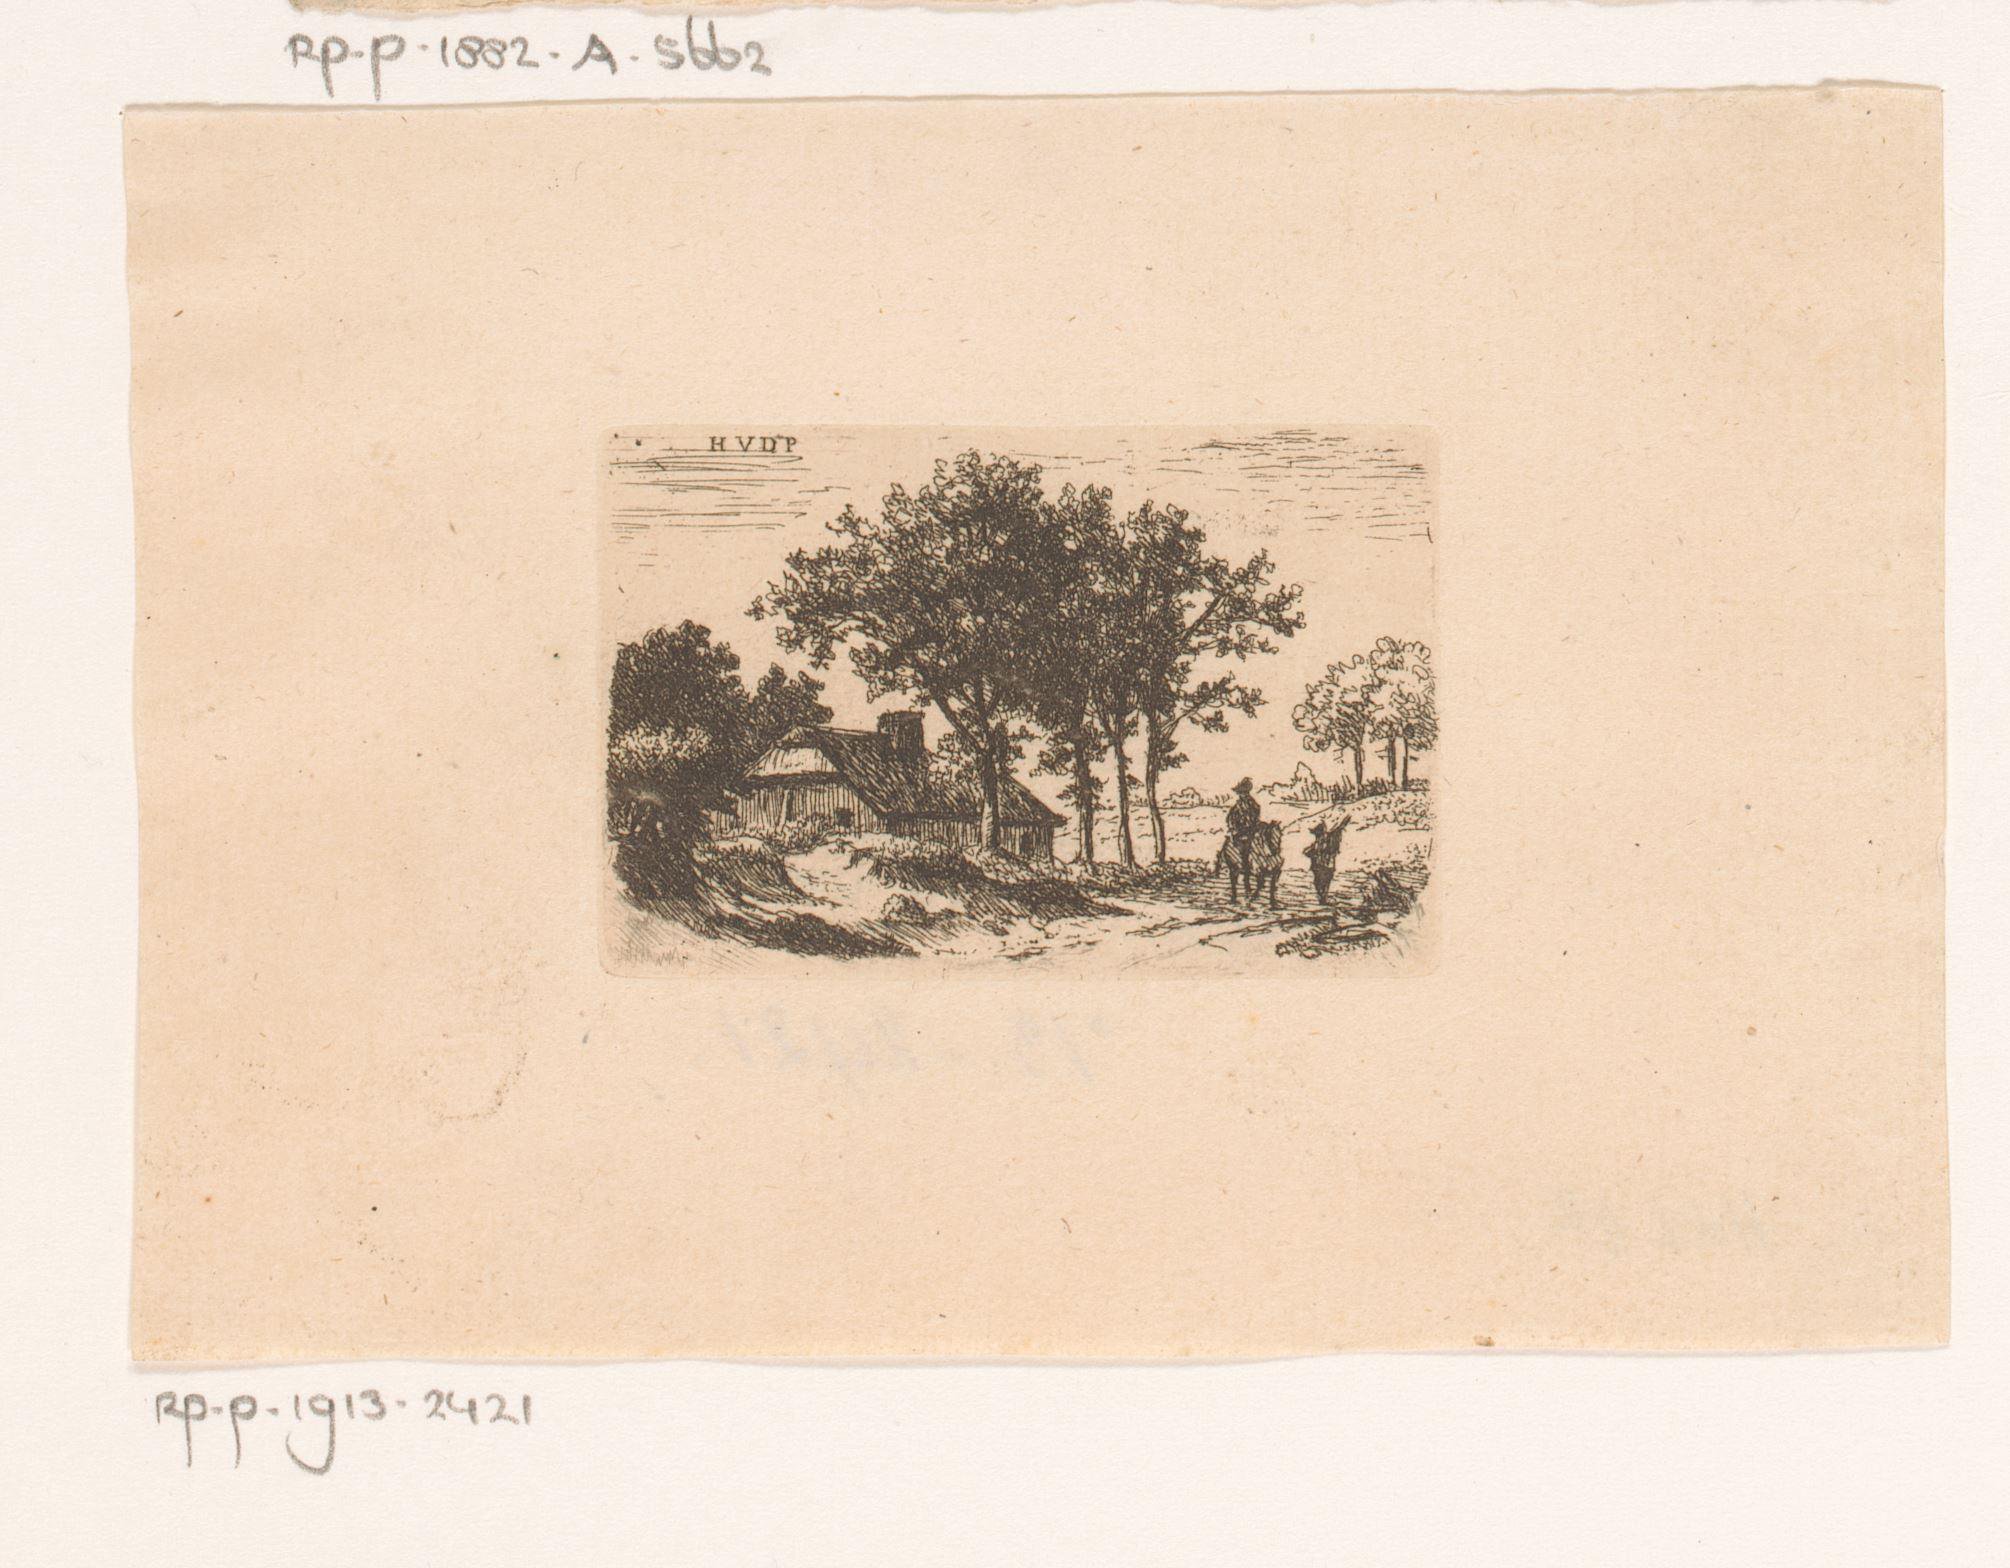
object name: print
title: Ruiter en wandelaar bij een boerderij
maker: hendrik jozef franciscus van der poorten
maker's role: draughtsman, print maker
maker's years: 1789-1874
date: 1799-1874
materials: paper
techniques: drypoint, etching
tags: farm or solitary house in landscape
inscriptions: collector's mark: Lugt 2228